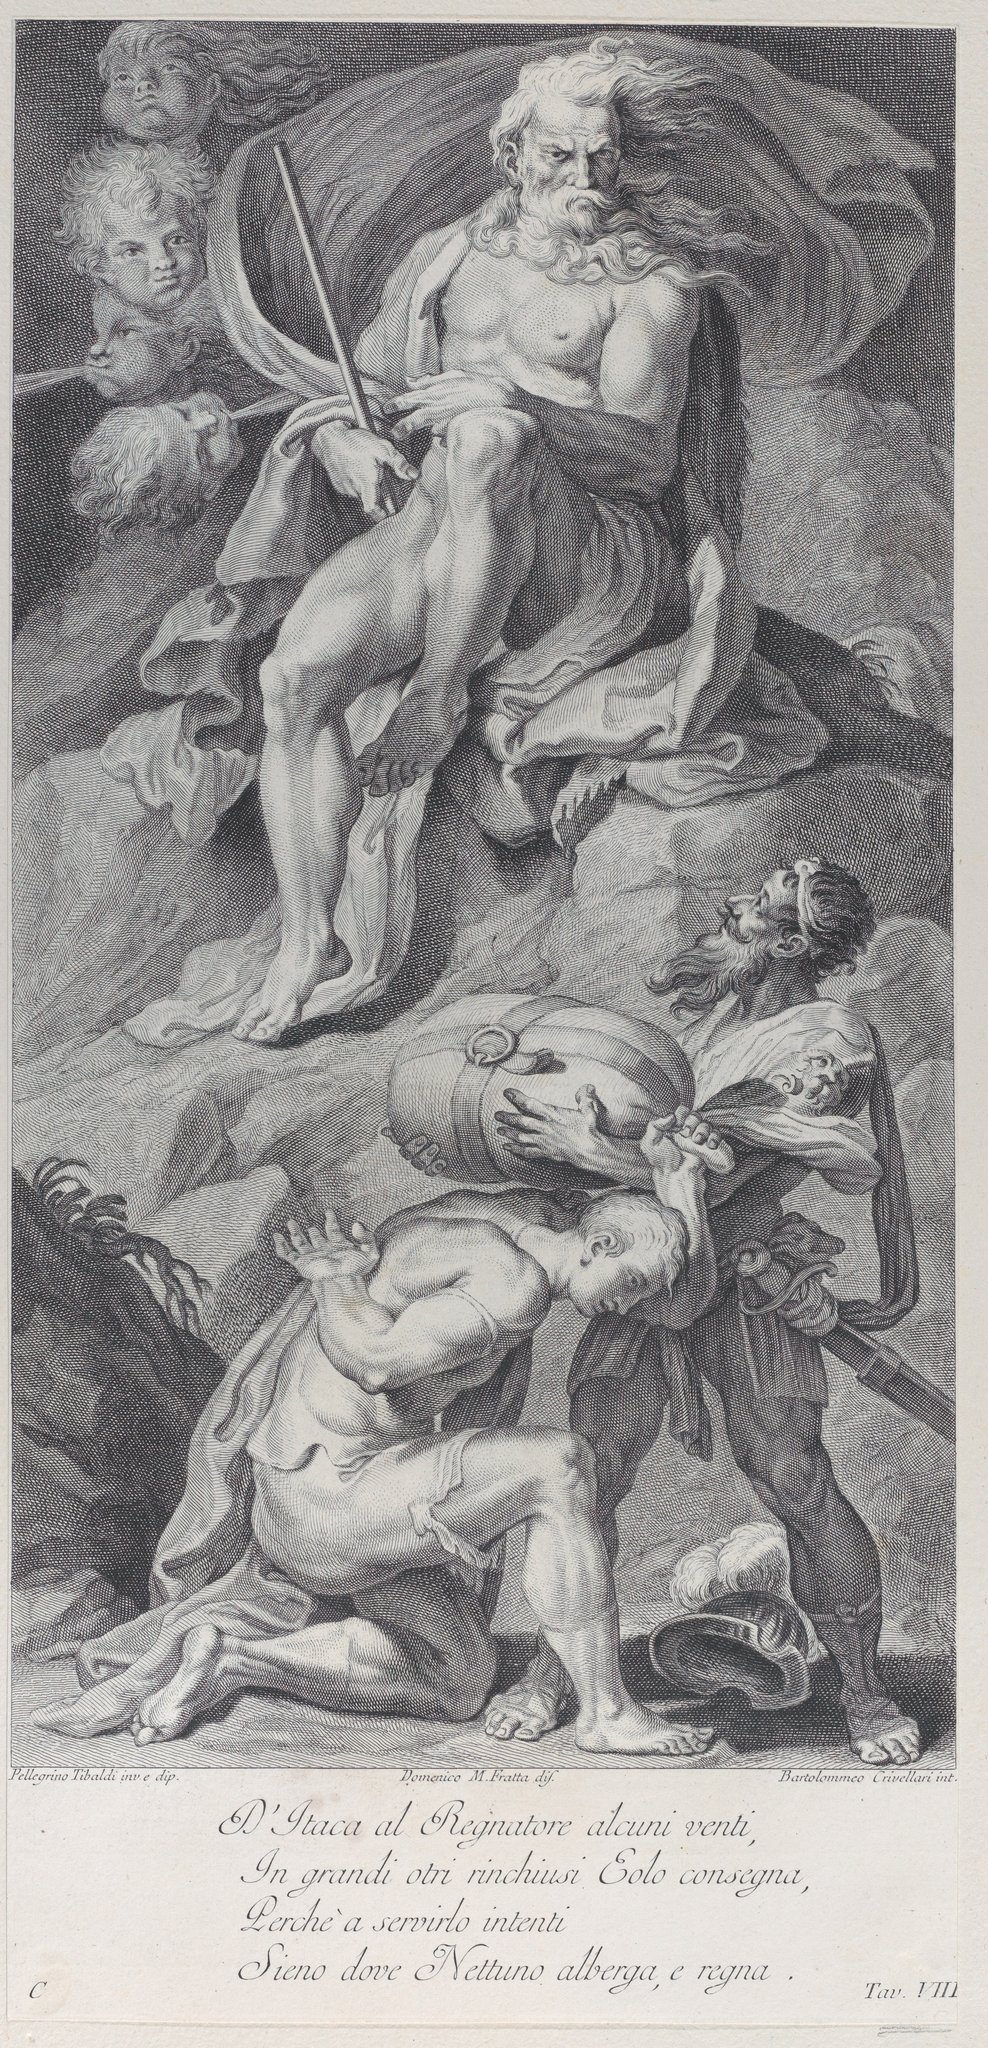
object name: print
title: Plate 8: Ulysses receiving the winds in a leather bag from Aeolus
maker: bartolomeo crivellari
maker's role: artist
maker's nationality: italian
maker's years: 1700-1800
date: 1756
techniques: engraving, etching